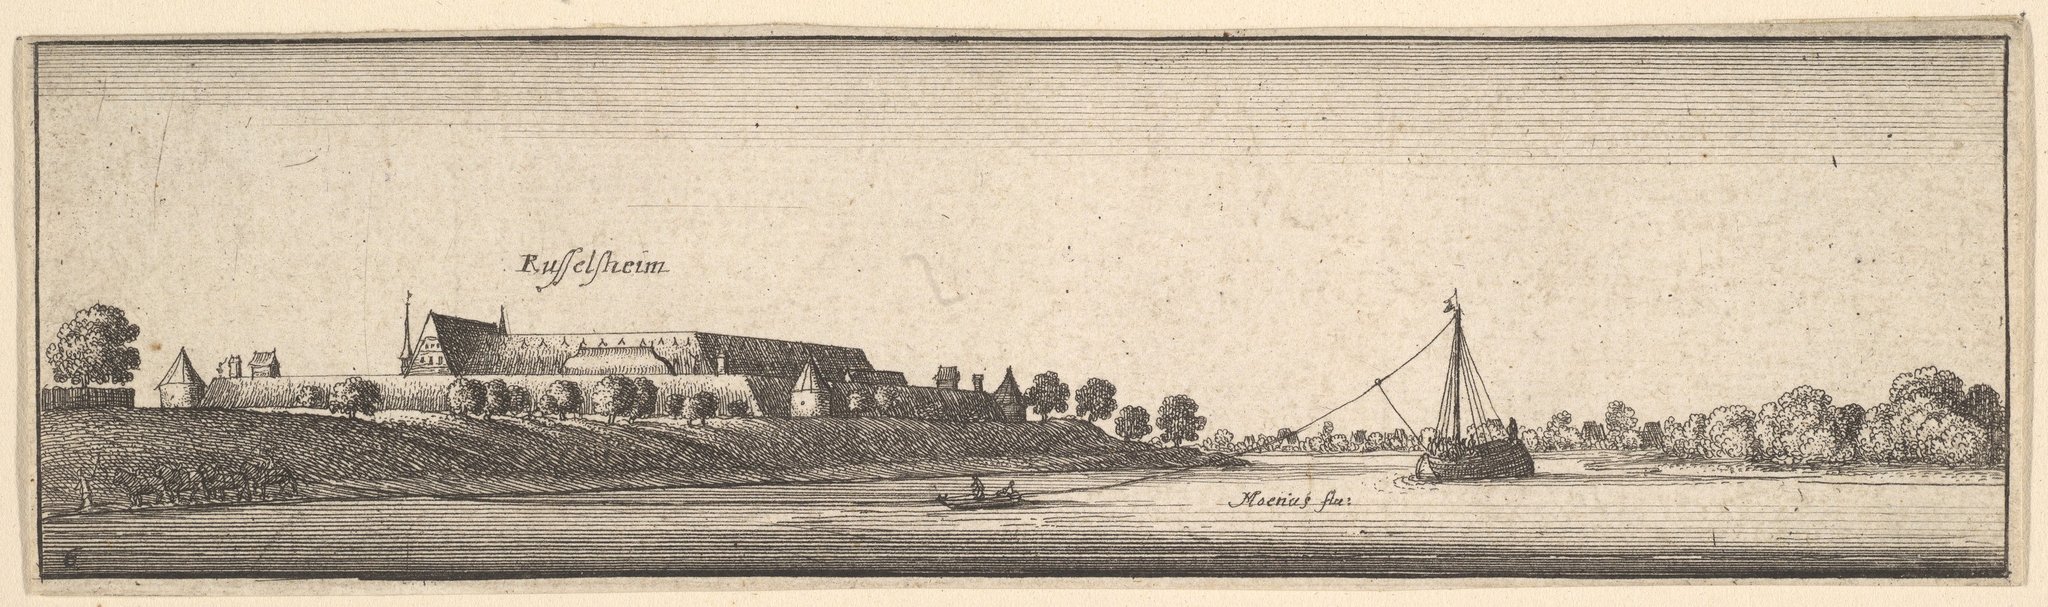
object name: print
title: Rüsselsheim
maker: wenceslaus hollar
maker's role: artist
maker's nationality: bohemian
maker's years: 1607-1677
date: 1642-1644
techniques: etching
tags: buildings,rivers,trees,boats,ships